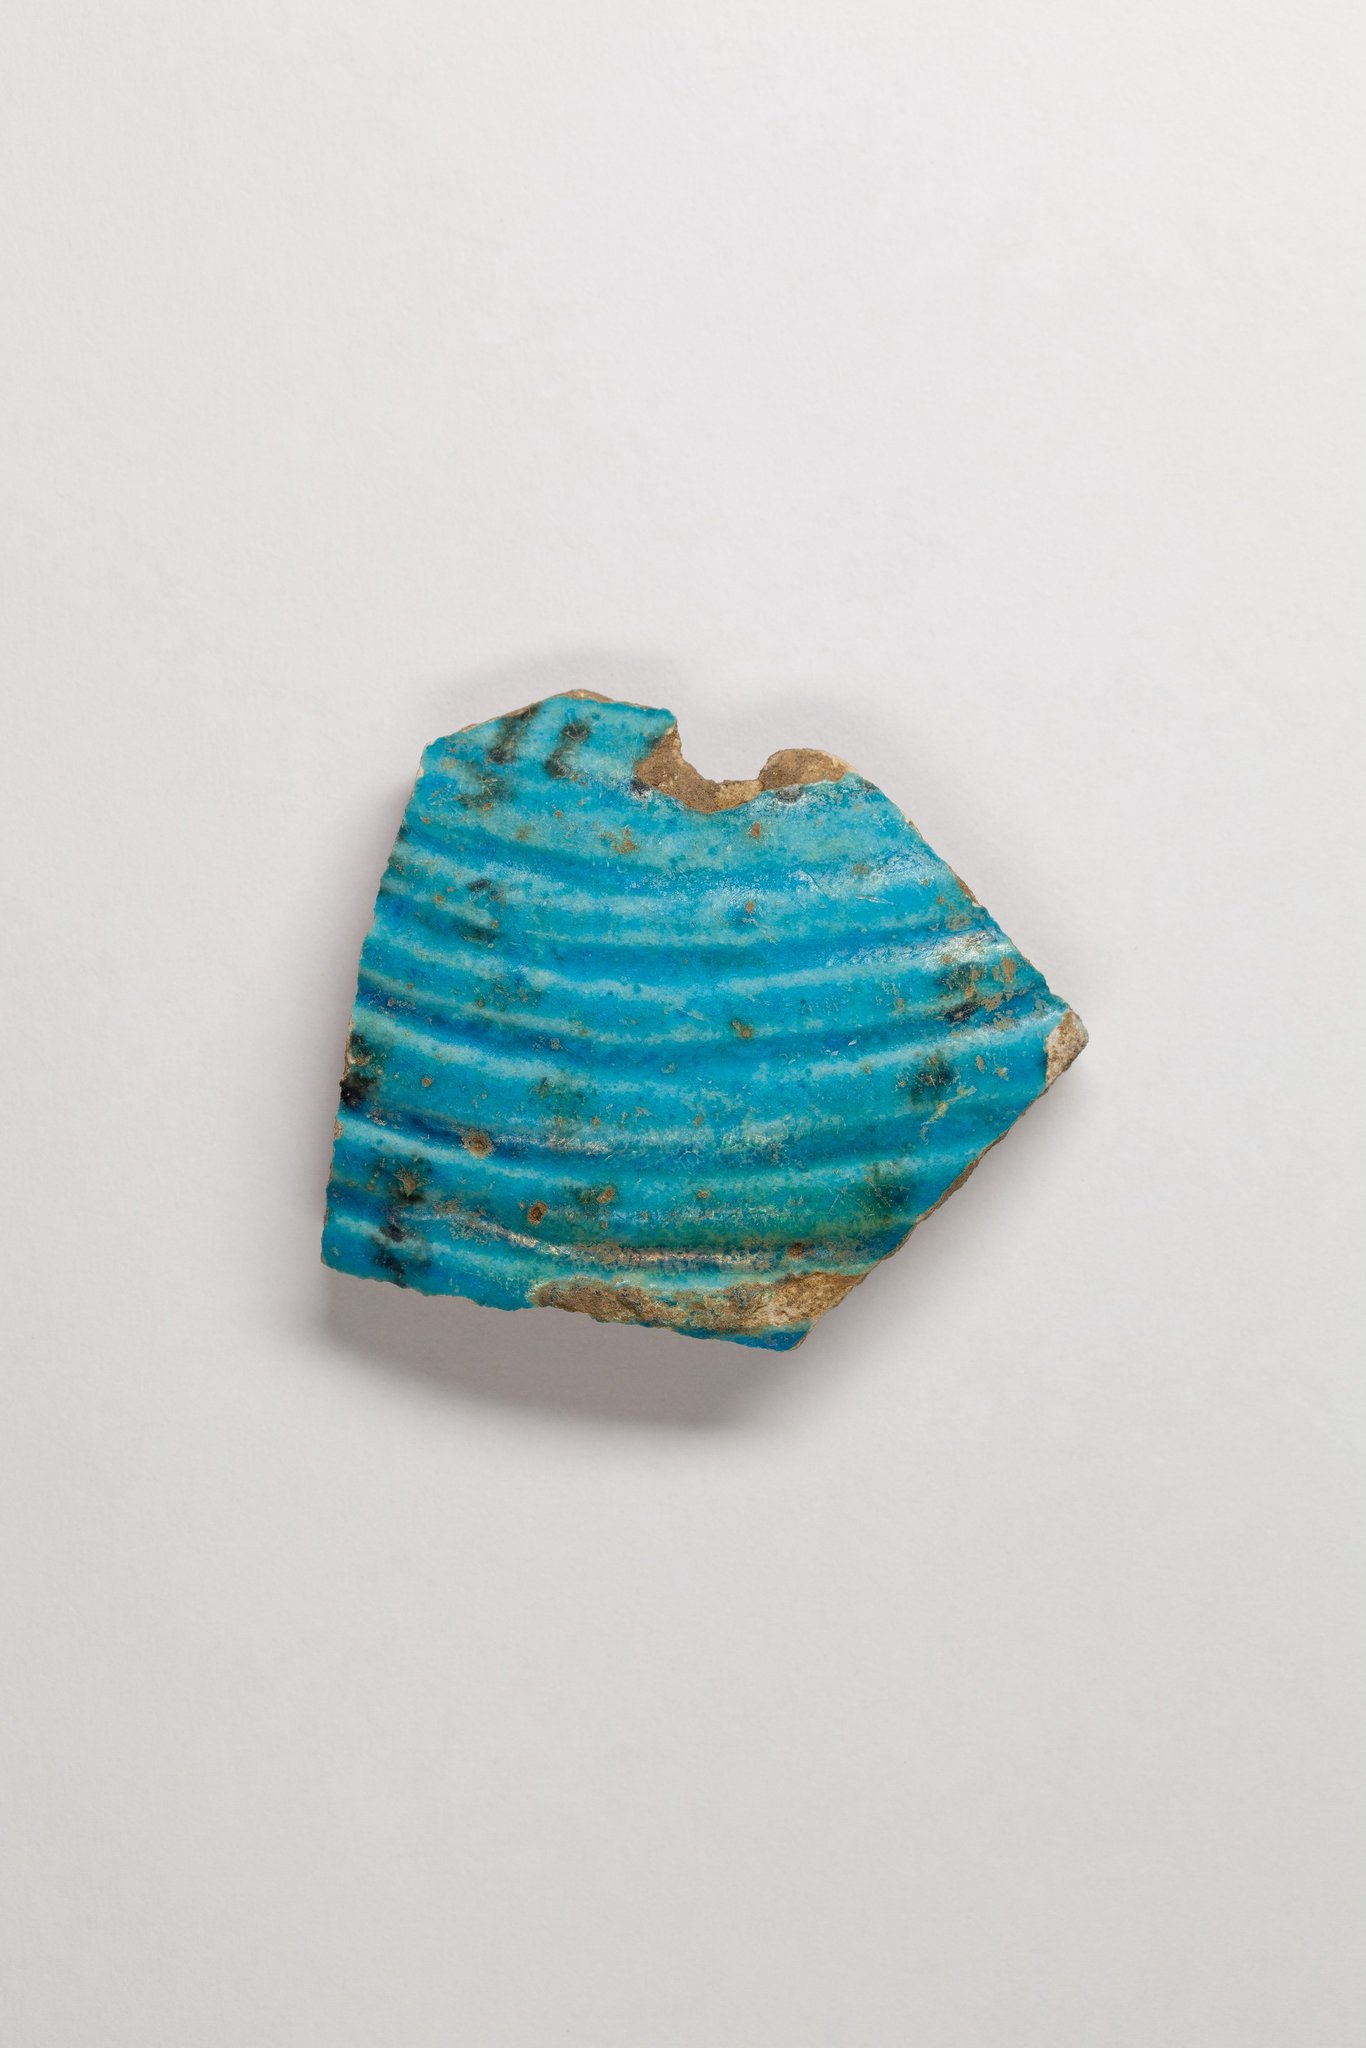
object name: vase fragment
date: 1981-1640 BCE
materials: faience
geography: egypt